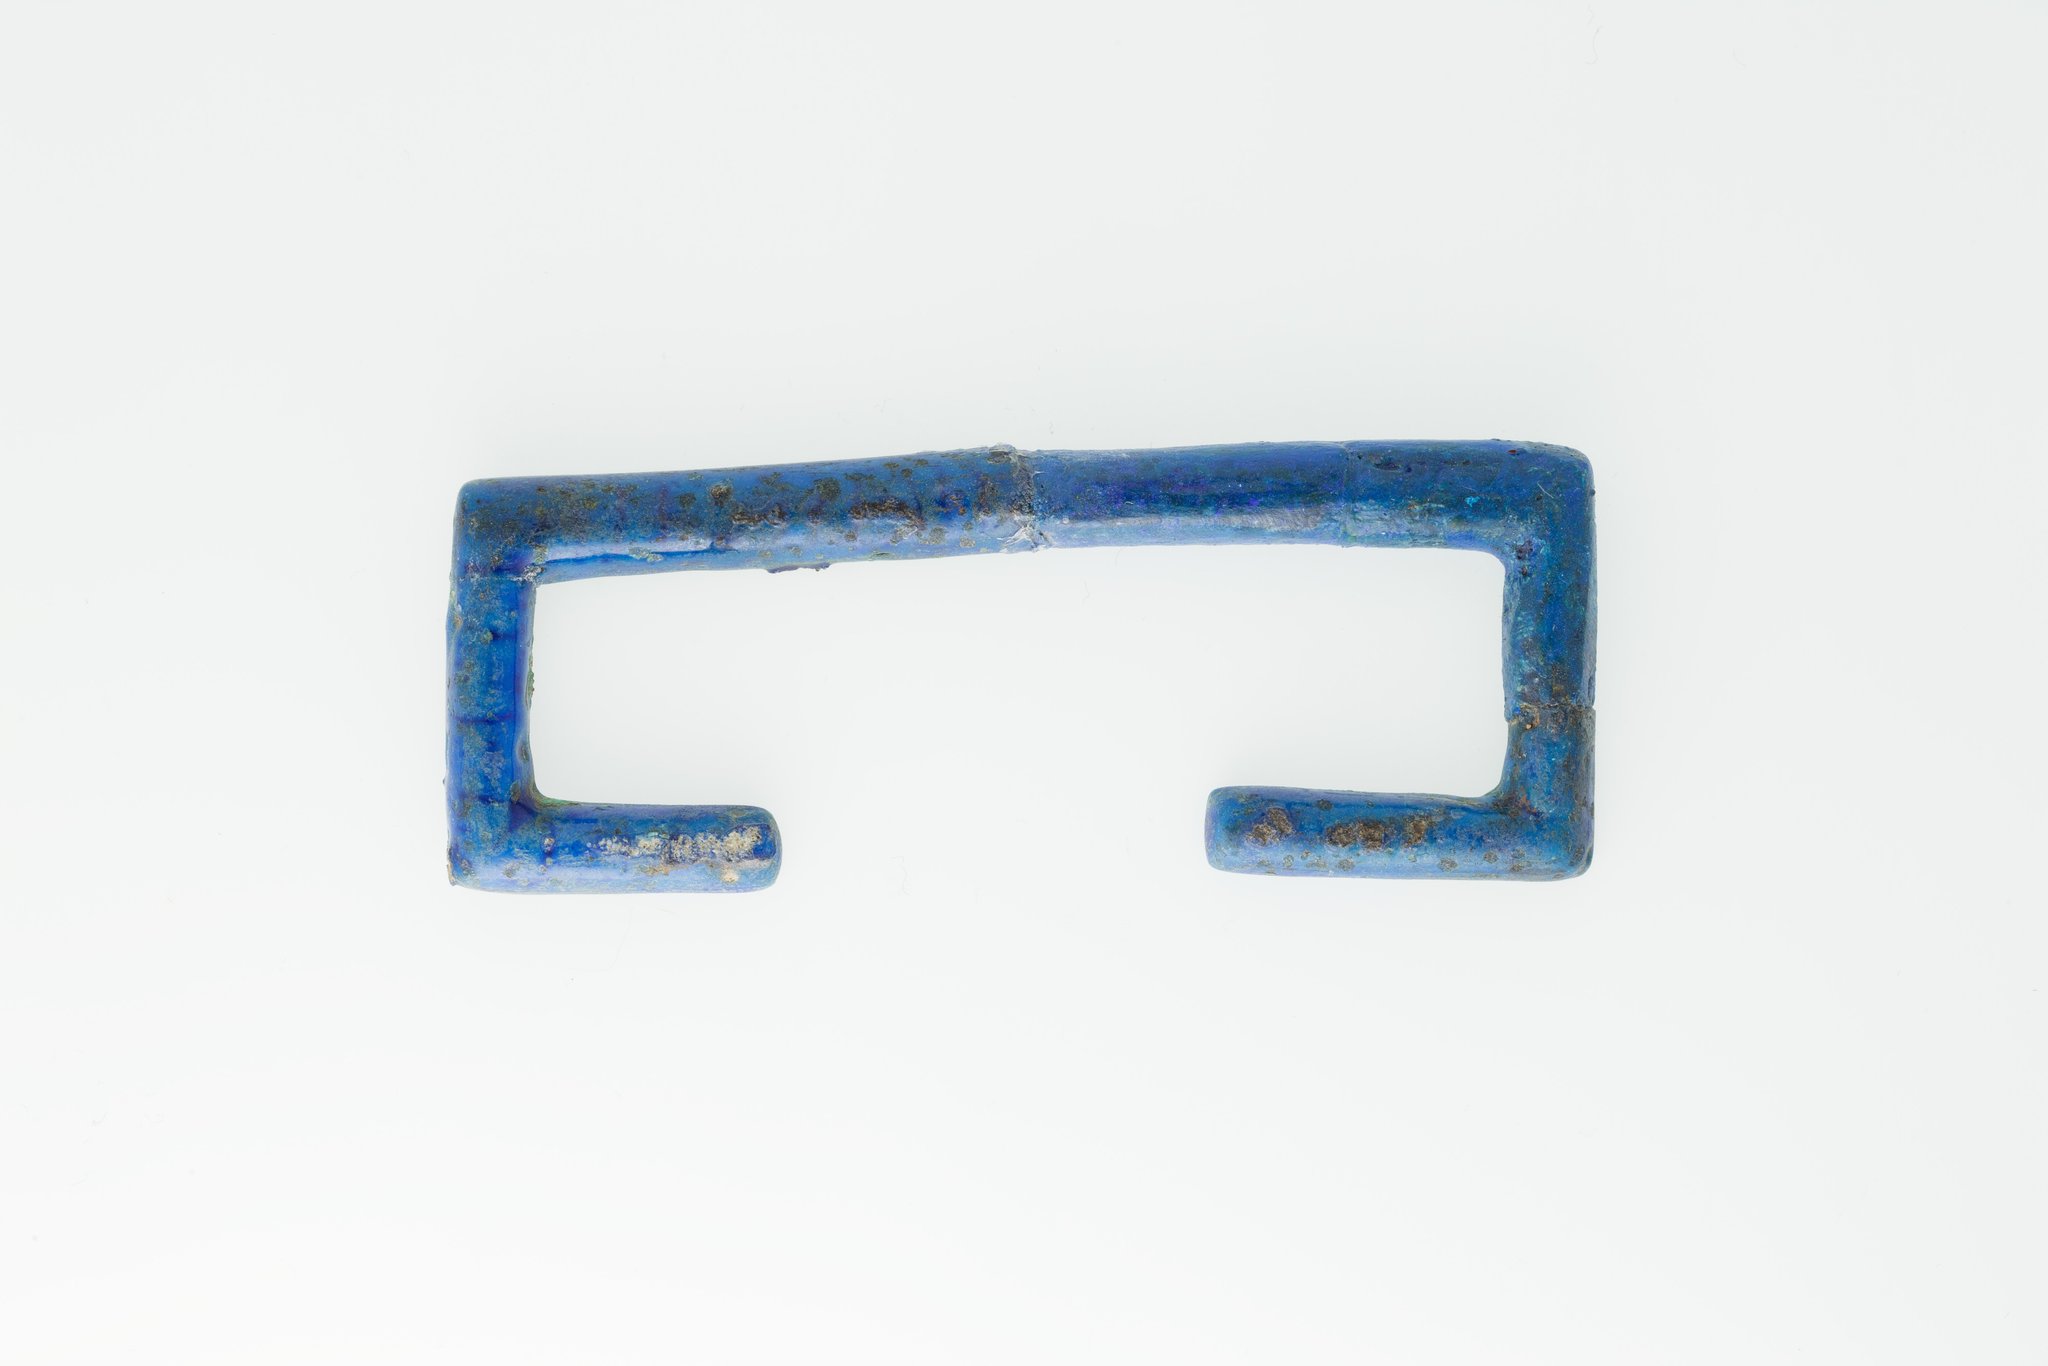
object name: inlay, hieroglyph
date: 664-610 BCE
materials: faience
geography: egypt